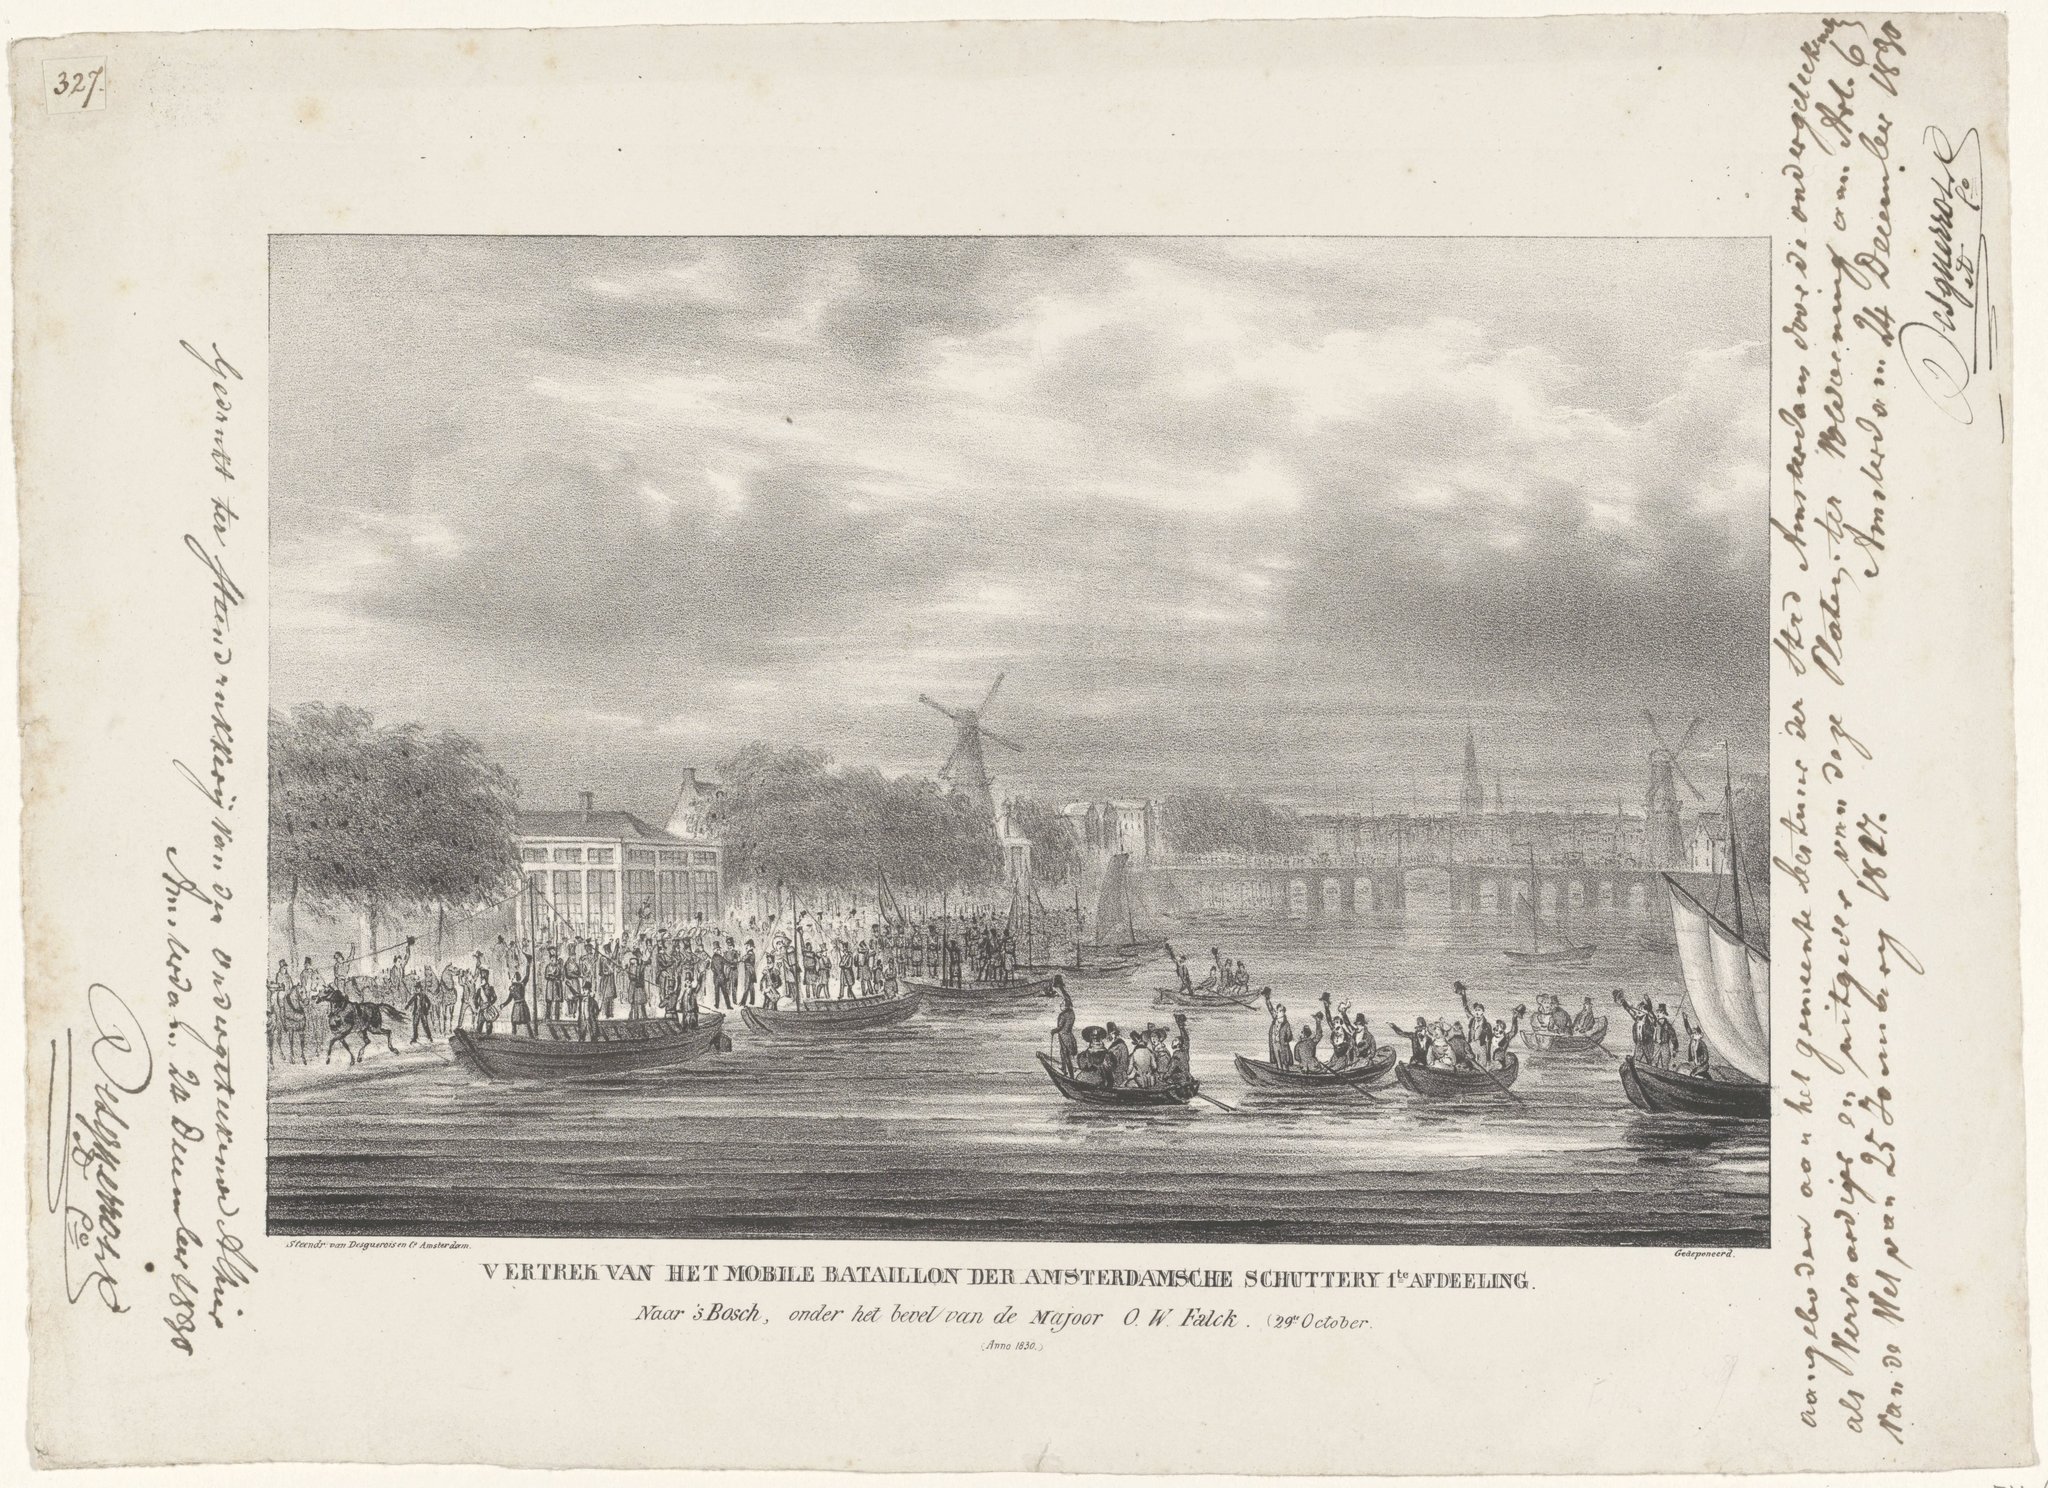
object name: print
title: Vertrek van de vrijwillige Amsterdamse schutterij, 1830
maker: Anonymous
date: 1830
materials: paper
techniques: lithograph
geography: netherlands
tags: leave-taking (of soldiers), waving farewell ~ departure on a journey, amsterdam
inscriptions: label: ‘327’, collector's mark: Lugt 2228, : ‘[links] Gedrukt ter Steendrukkerij van den ondergeteekende Alhier Amsterdam, 24 December 1830 Desguerrois & Co. / [rechts] aangeboden aan het gemeente bestuur der Stad Amsterdam door de ondergeteekenden als Vervaardiger en uitgever van deze Platen, ter voeldoening aan Art. 6 van de Wet van 25 January 1817. Desguerrois et Co’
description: Vertrek van het Mobiele Bataljon van de vrijwillige Amsterdamse schutterij, eerste afdeling, onder commando van majoor Otto Willem Falck, naar Den Bosch op 29 oktober 1830. Inscheping in de trekschuiten op de Amstel voor de herberg de Berebijt. Rechts meerdere kleine bootjes op de Amstel, in de verte een brug, molens en torens van de stad. Zie ook de pendant. Met annotaties van de drukker.